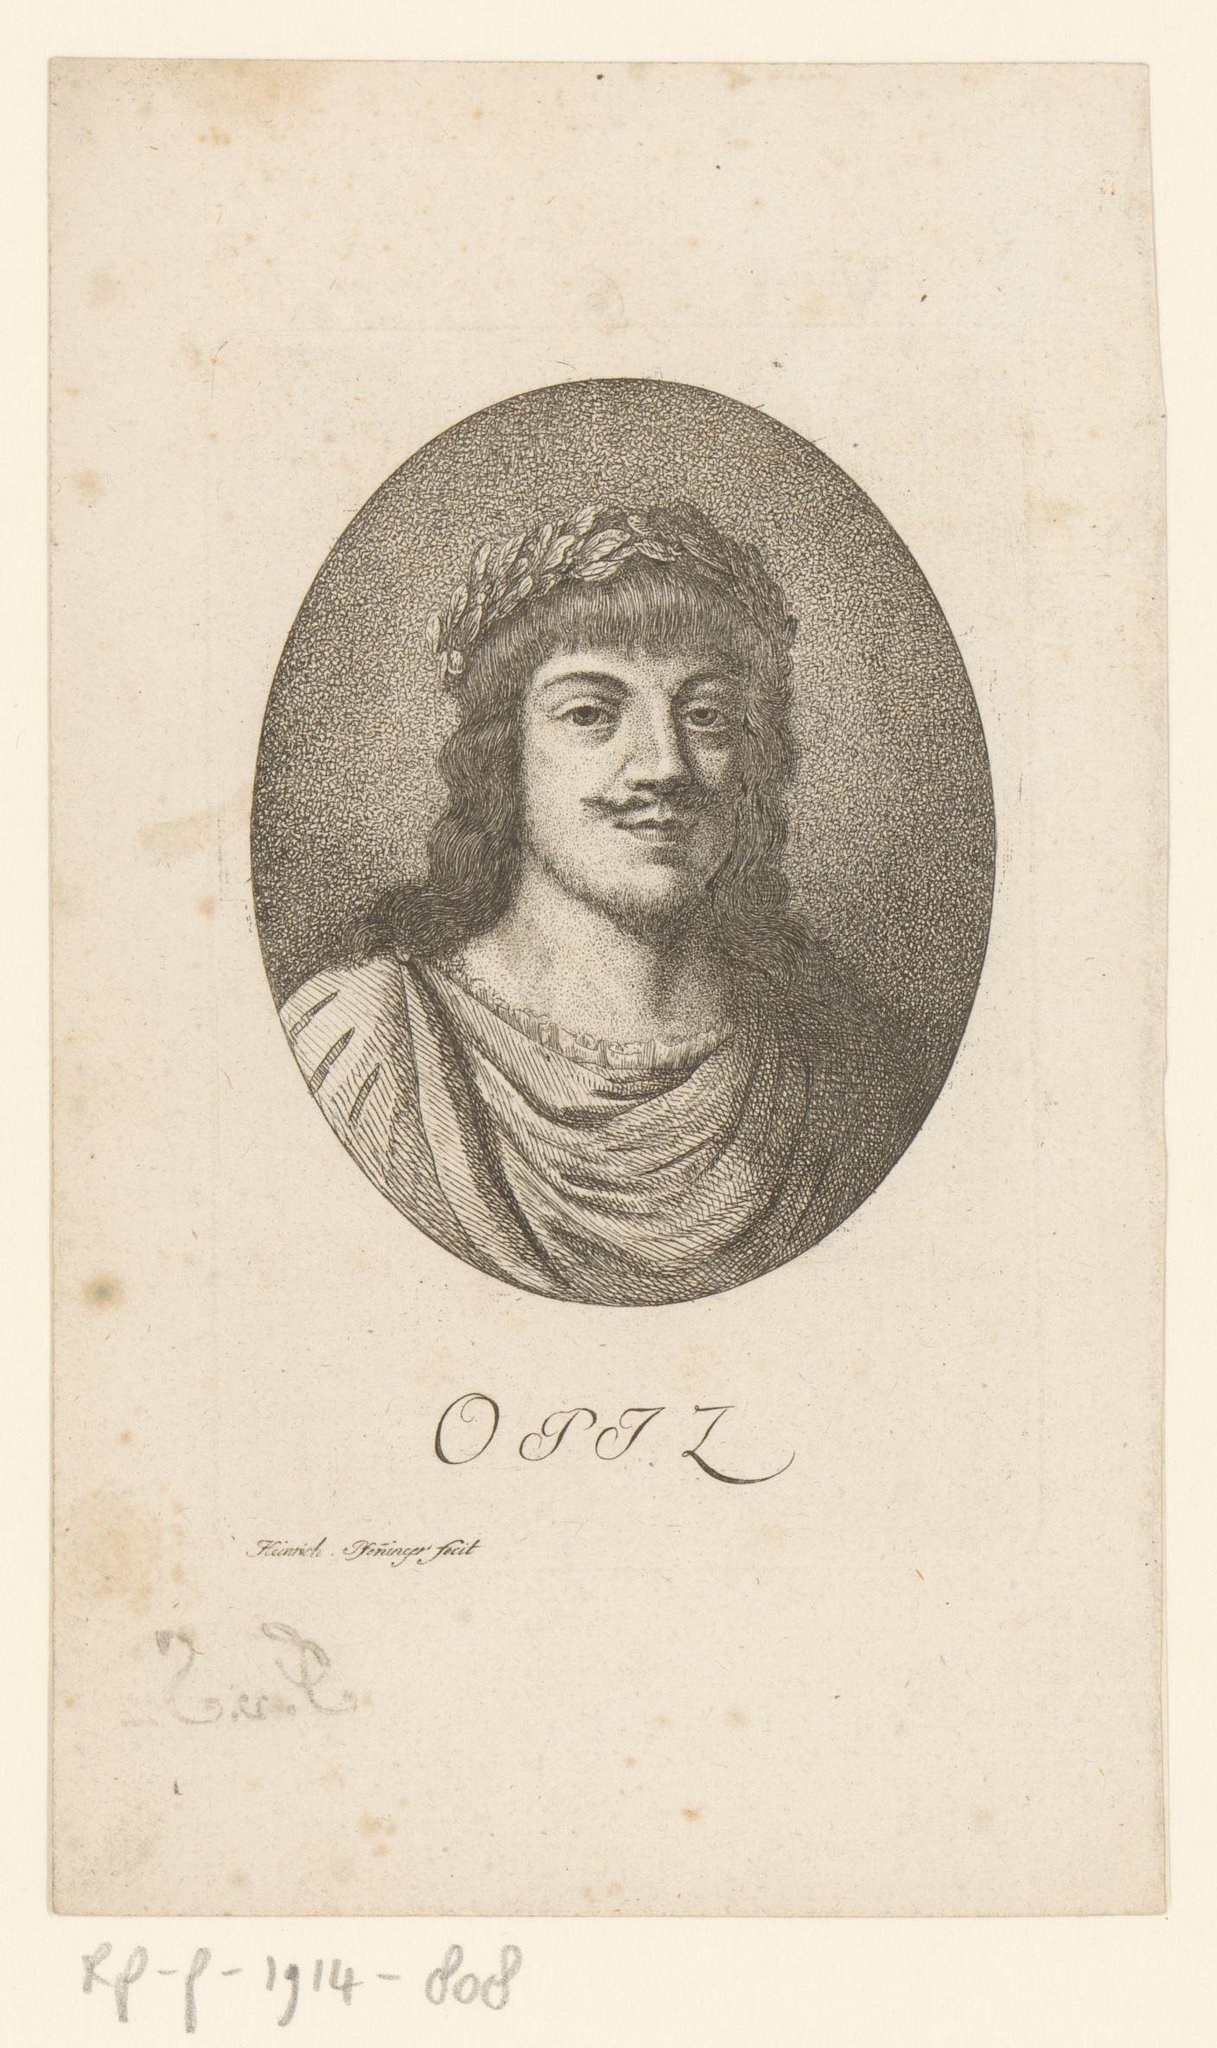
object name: print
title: Portret van Martin Opiz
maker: heinrich pfenninger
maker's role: print maker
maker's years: 1749-1815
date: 1759-1815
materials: paper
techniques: etching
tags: poland, martin opitz, historical persons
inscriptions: collector's mark: Lugt 2228